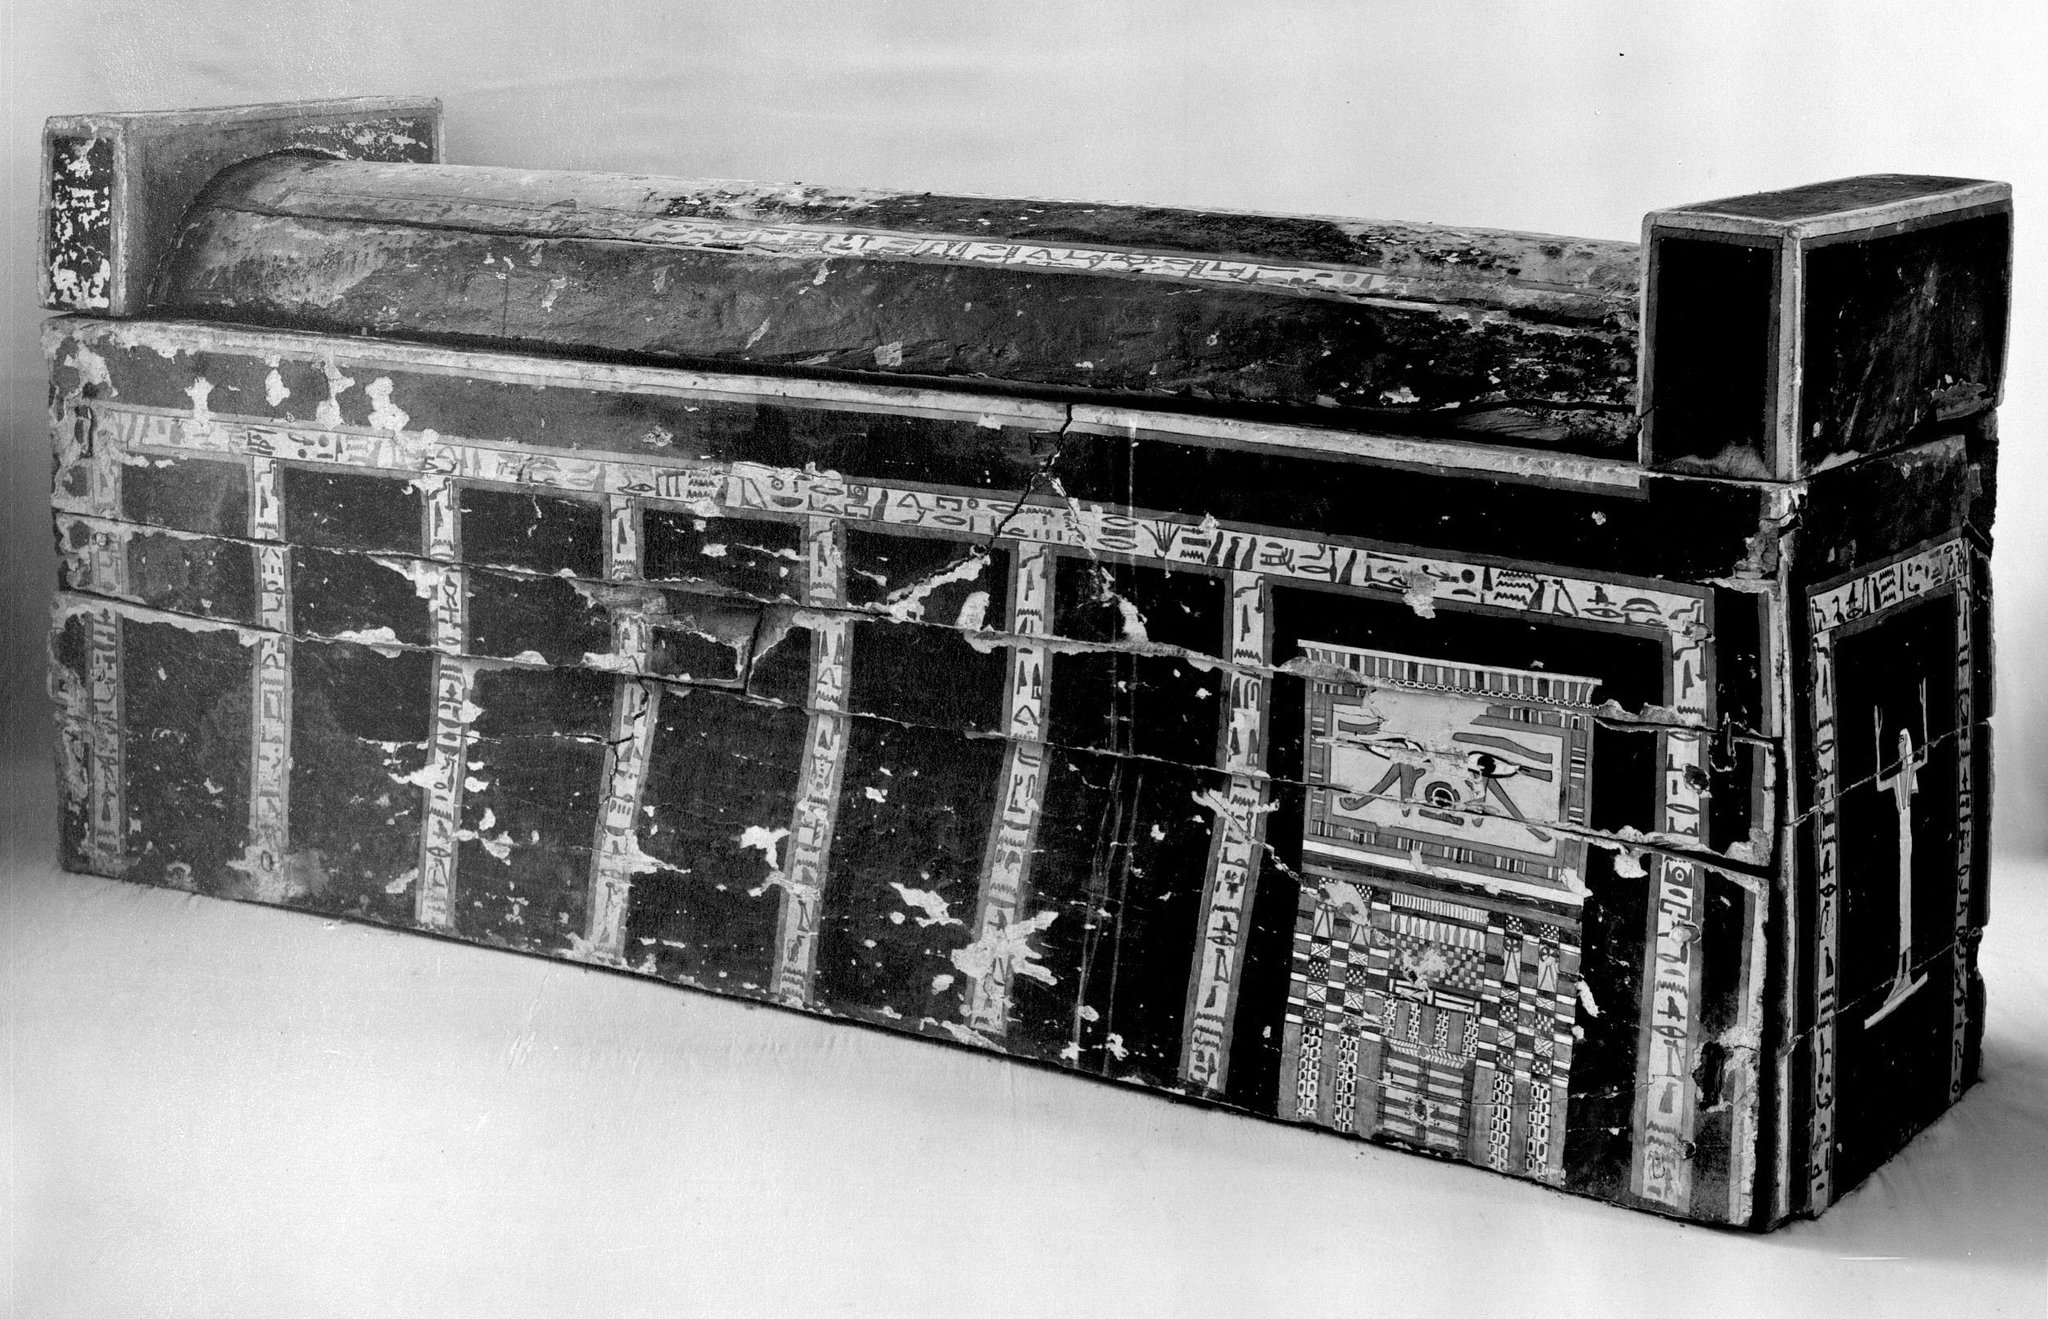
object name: coffin, ikhet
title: Coffin of Ikhet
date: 1802-1640 BCE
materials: wood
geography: egypt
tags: coffins